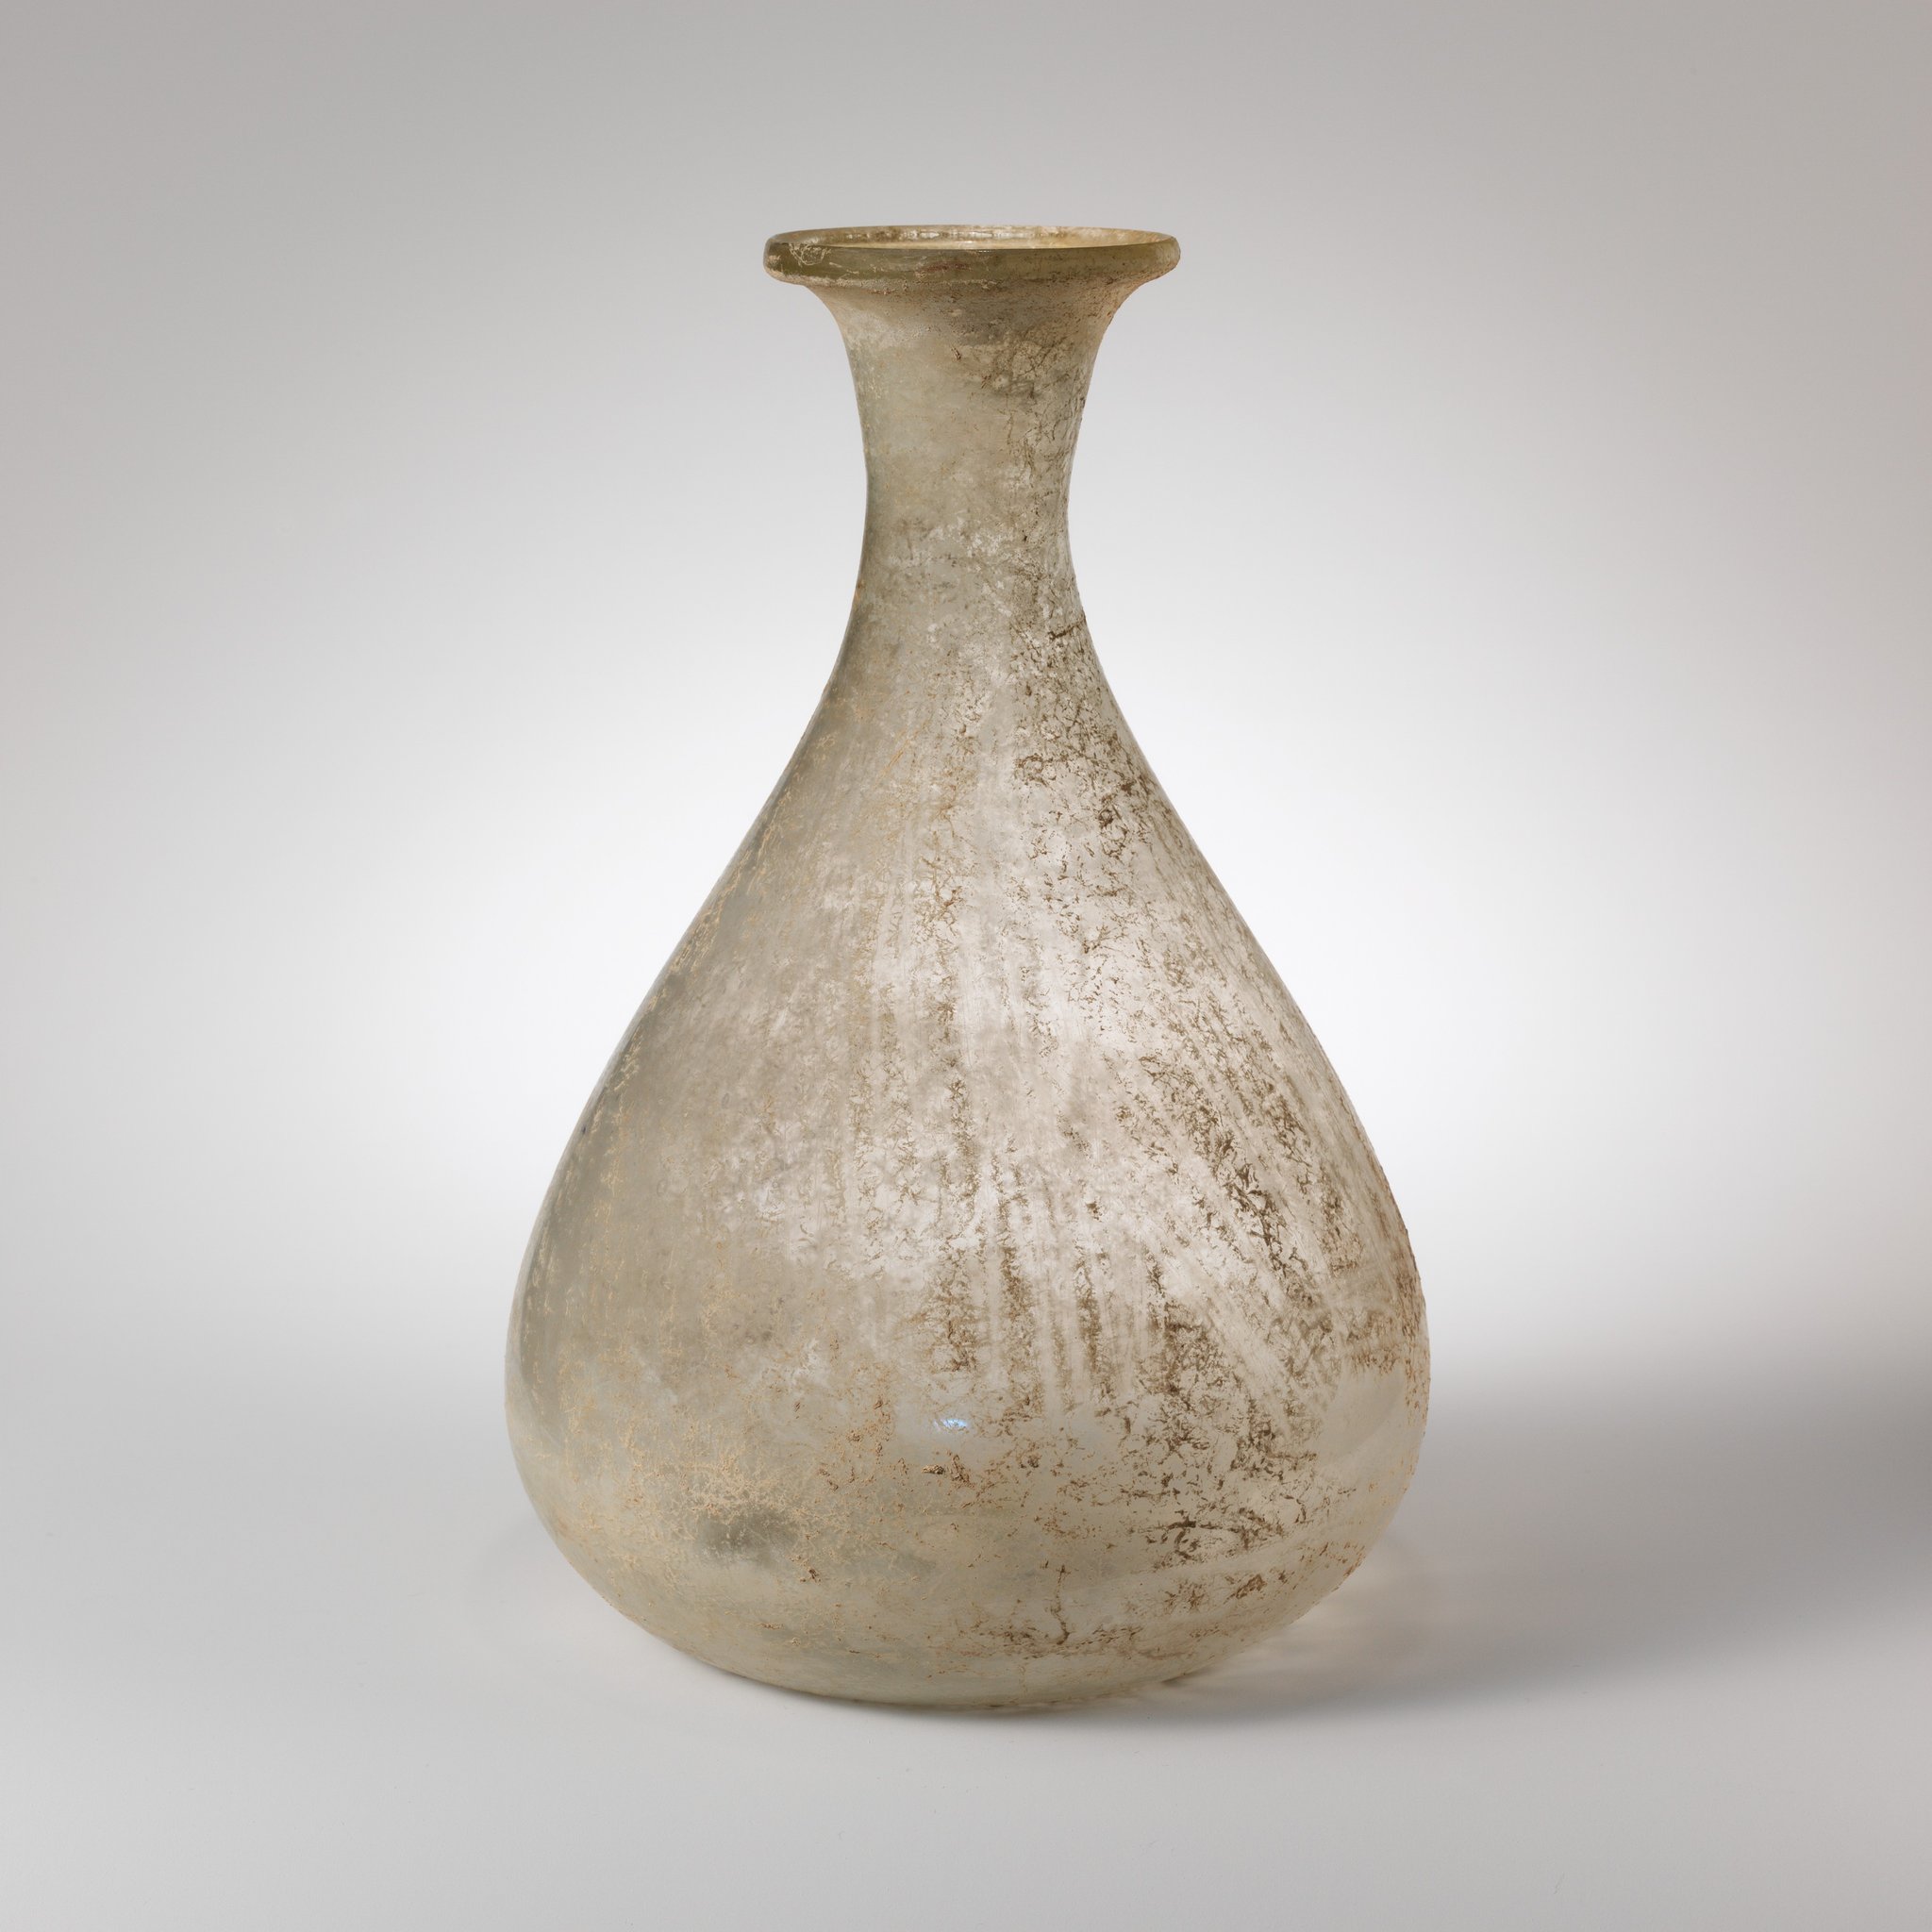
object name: flask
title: Glass flask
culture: roman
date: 101-300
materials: glass